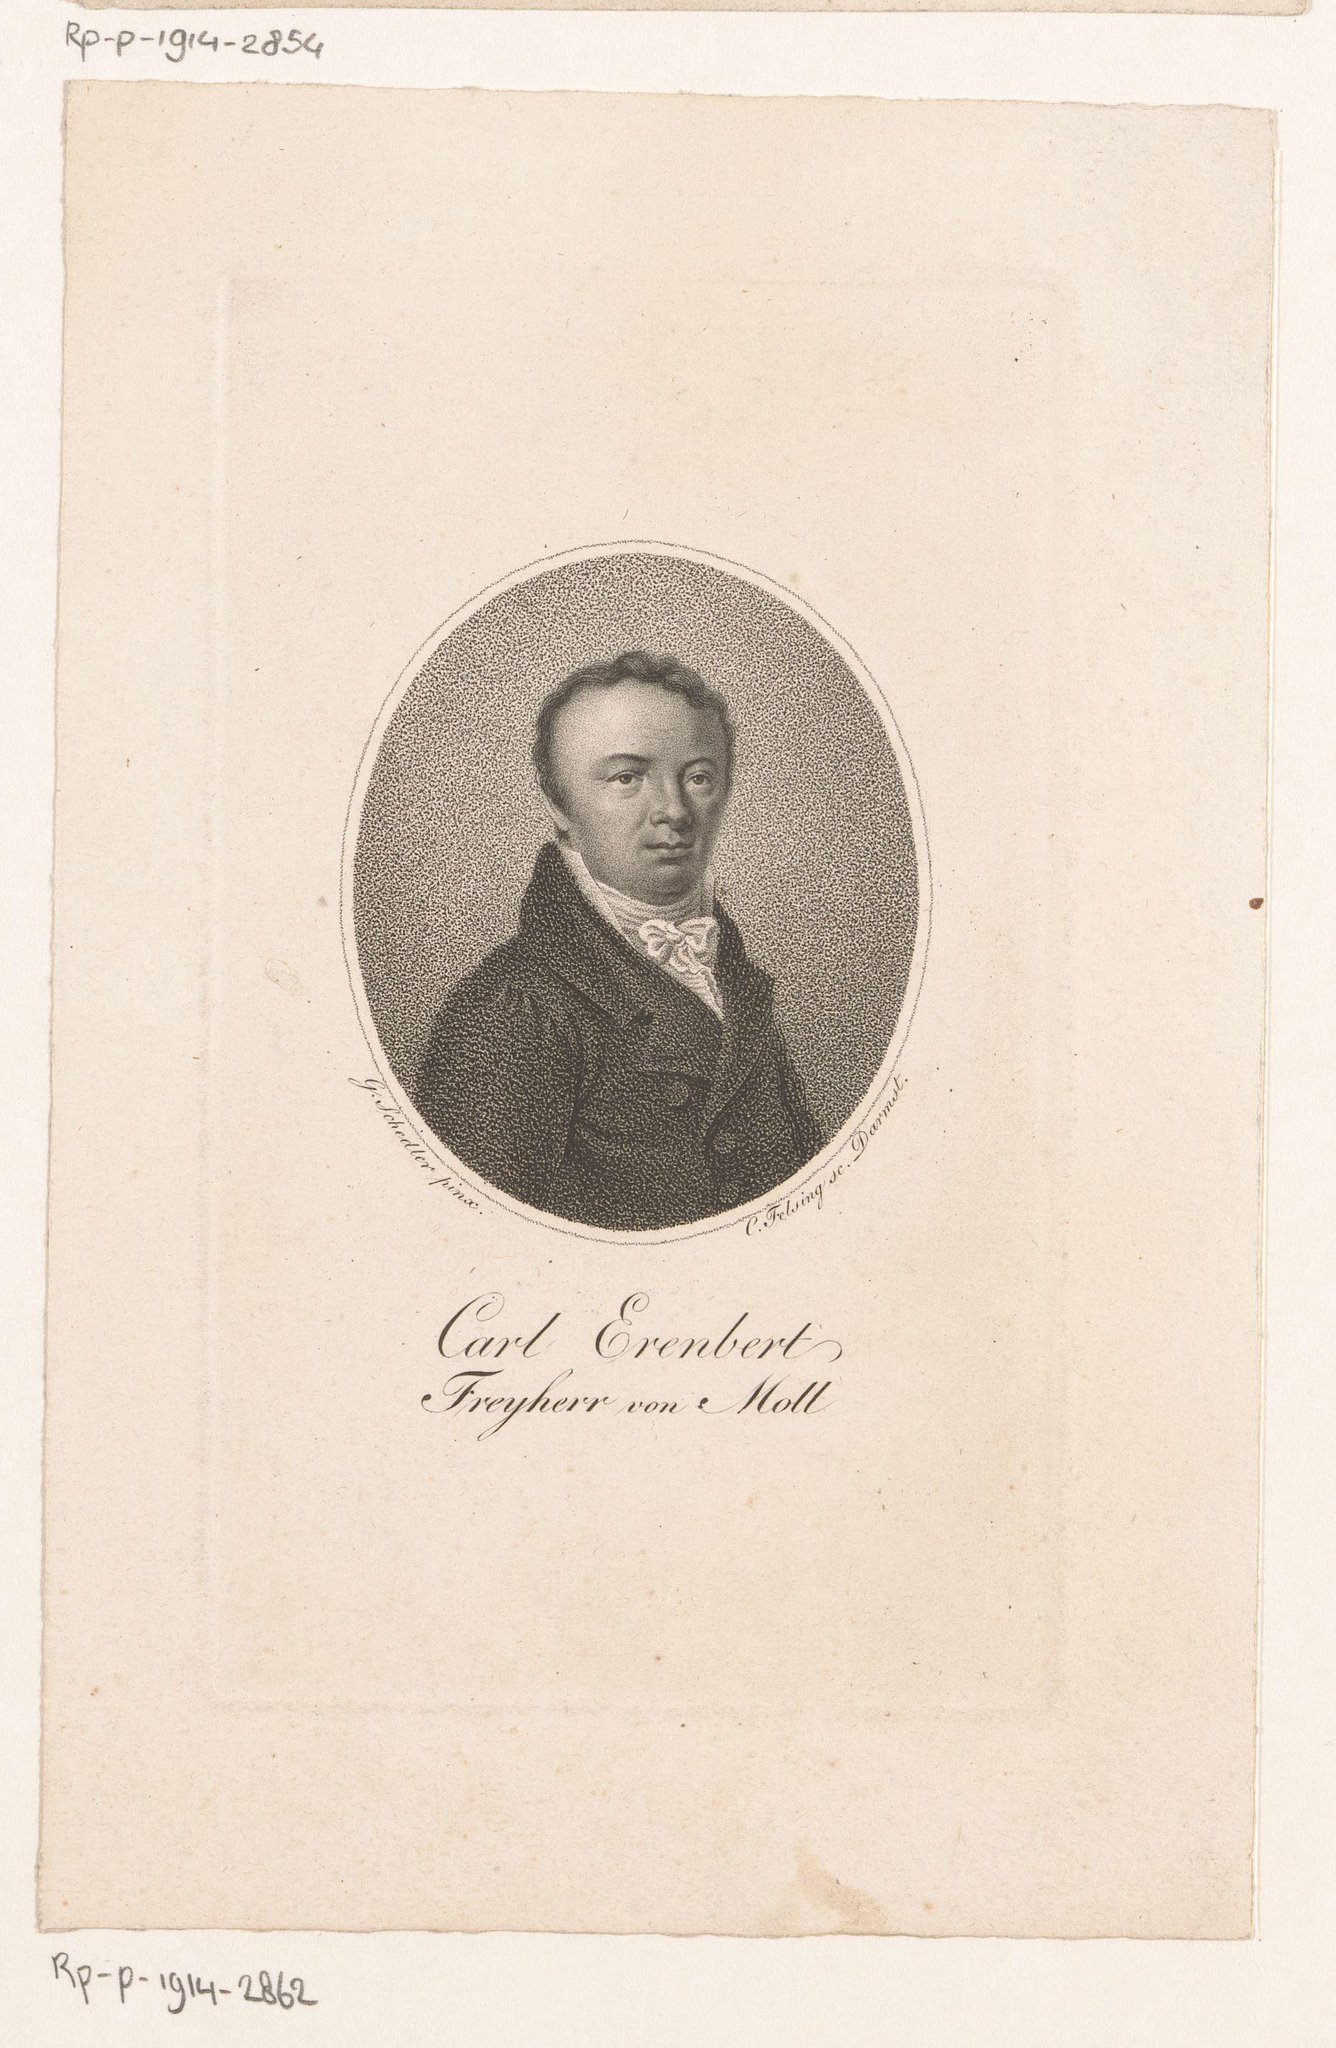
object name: print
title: Portret van Karl Ehrenbert von Moll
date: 1776-1819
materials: paper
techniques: engraving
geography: darmstadt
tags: historical persons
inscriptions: collector's mark: Lugt 2228